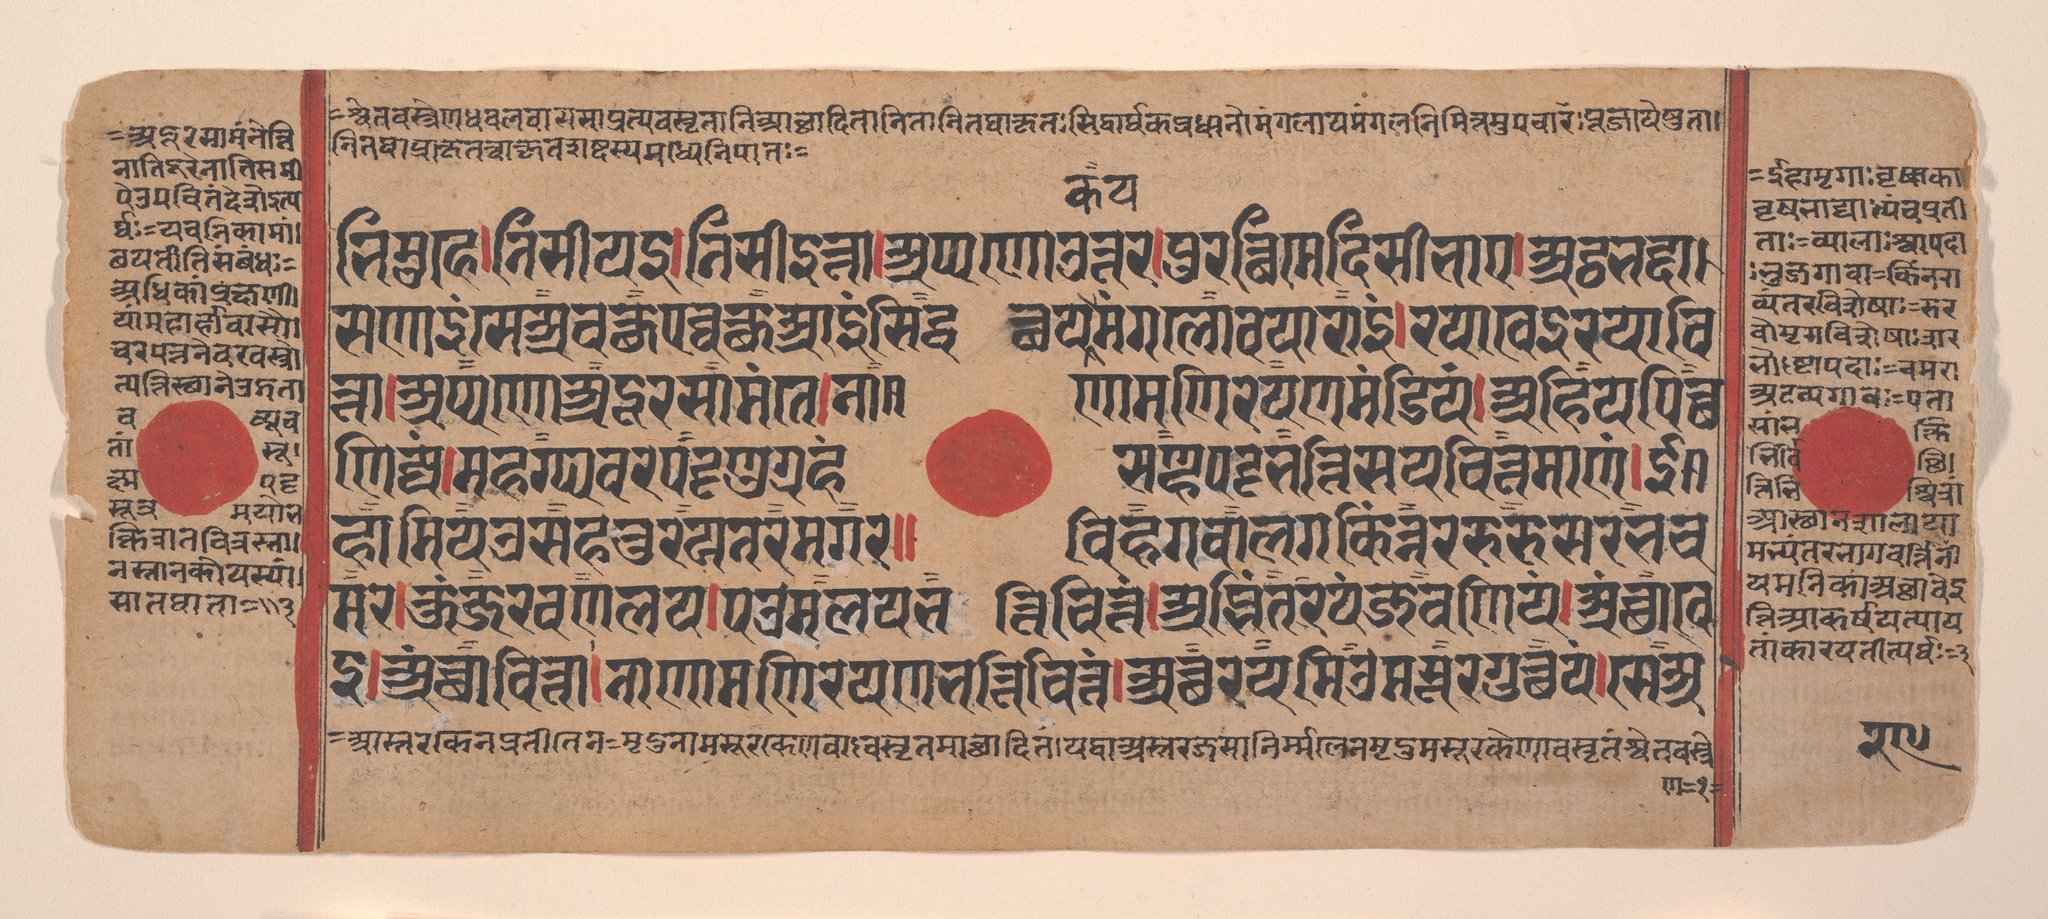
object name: folio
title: Page from a Dispersed Kalpa Sutra (Jain Book of Rituals)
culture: indian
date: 1401-1500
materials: gold, ink, paper, watercolor